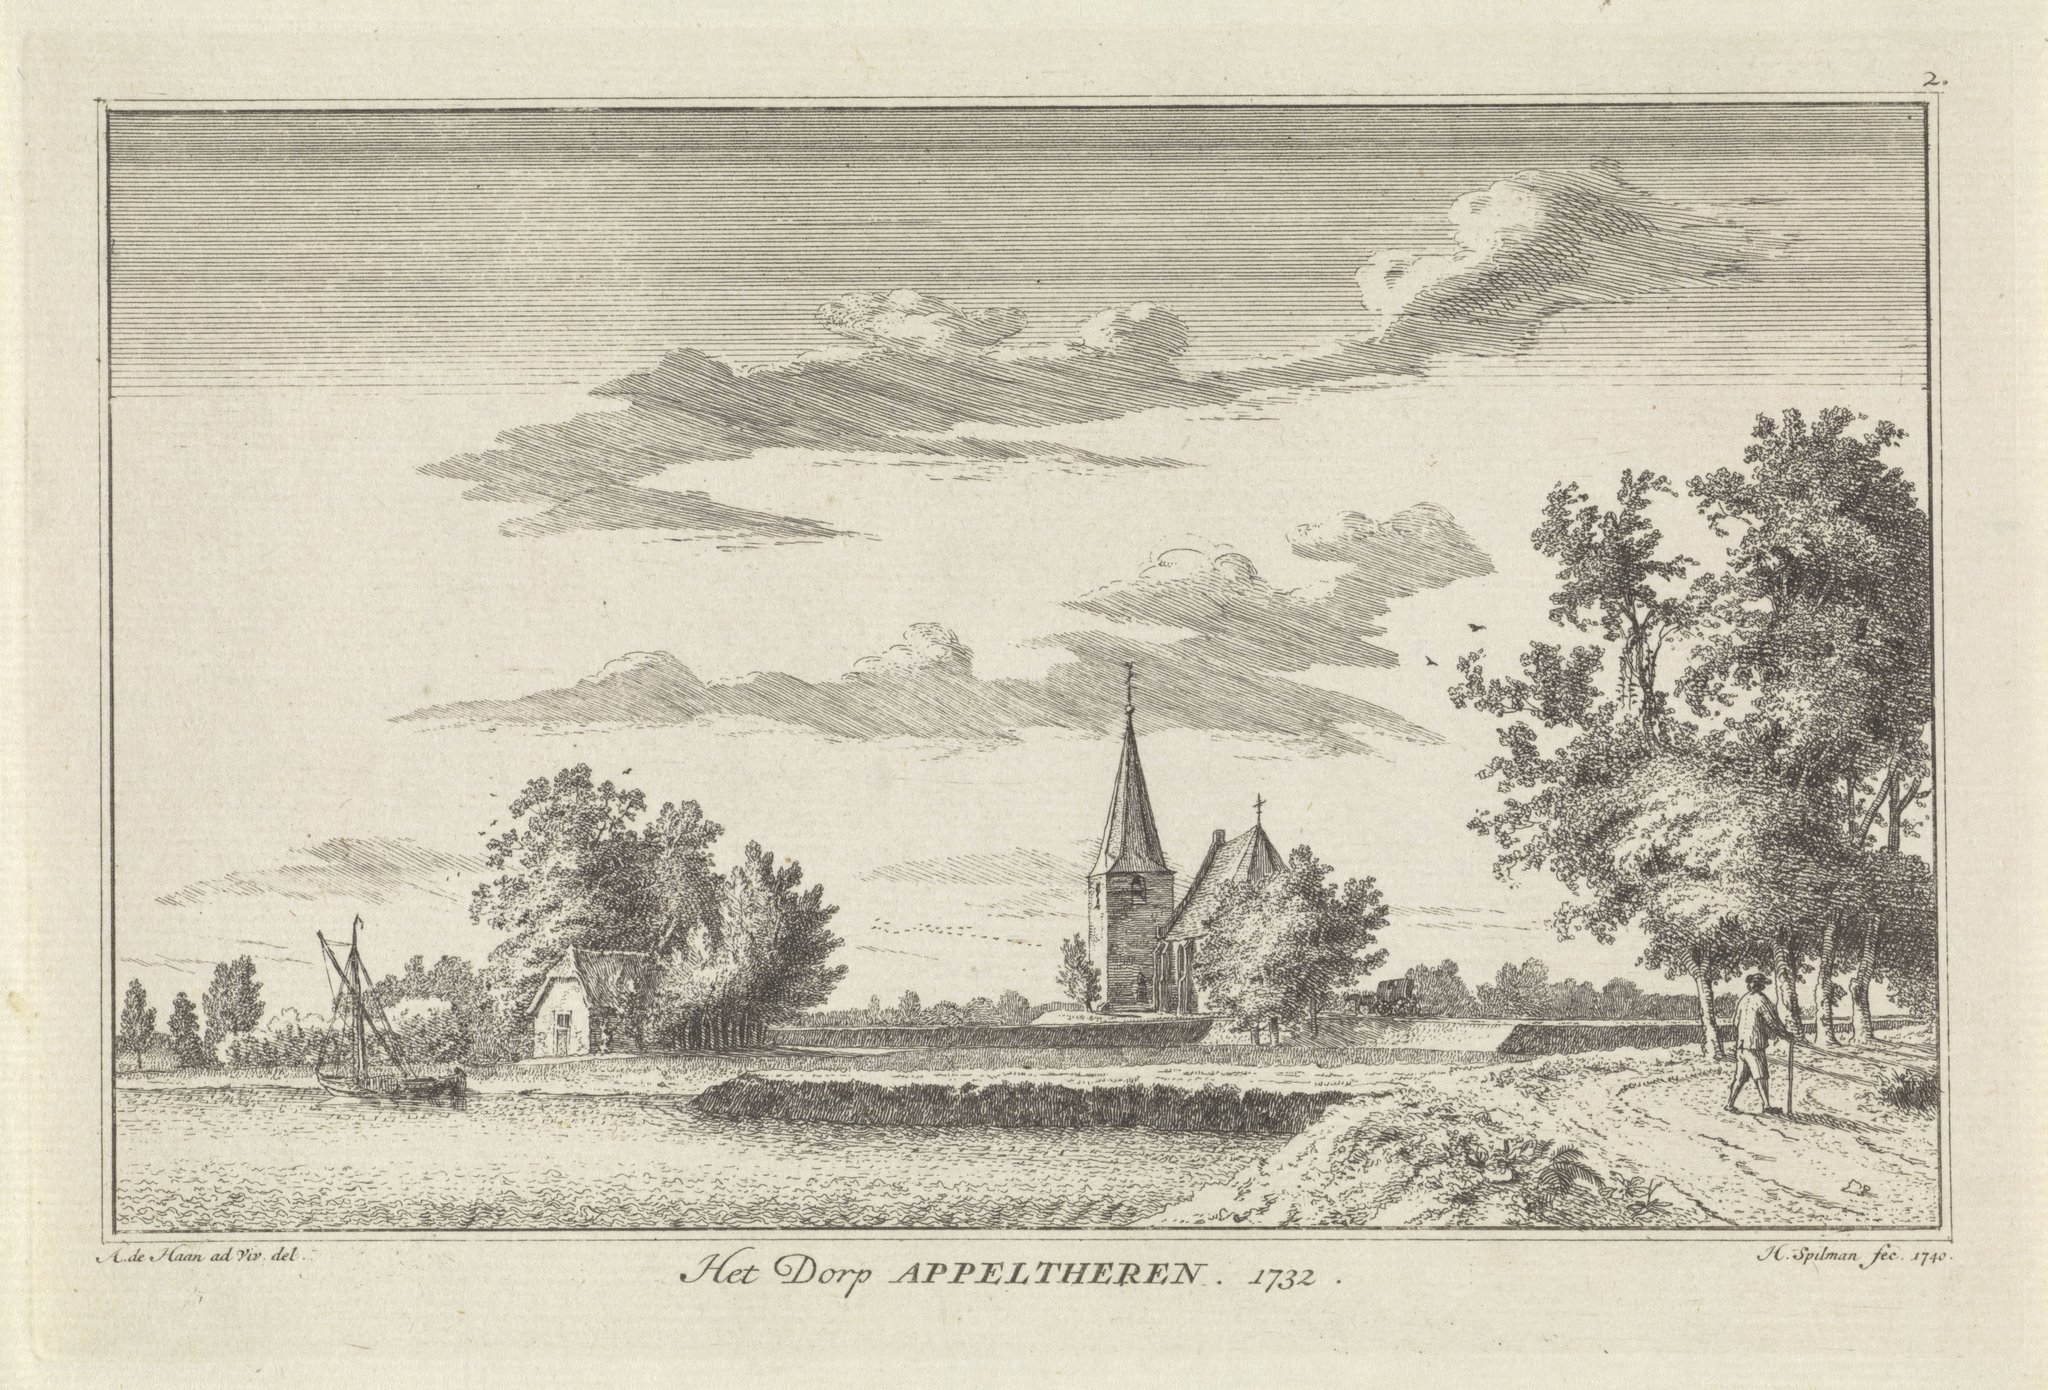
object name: print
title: Het Dorp Appeltheren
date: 1740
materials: paper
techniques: etching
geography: haarlem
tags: church (exterior)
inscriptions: date